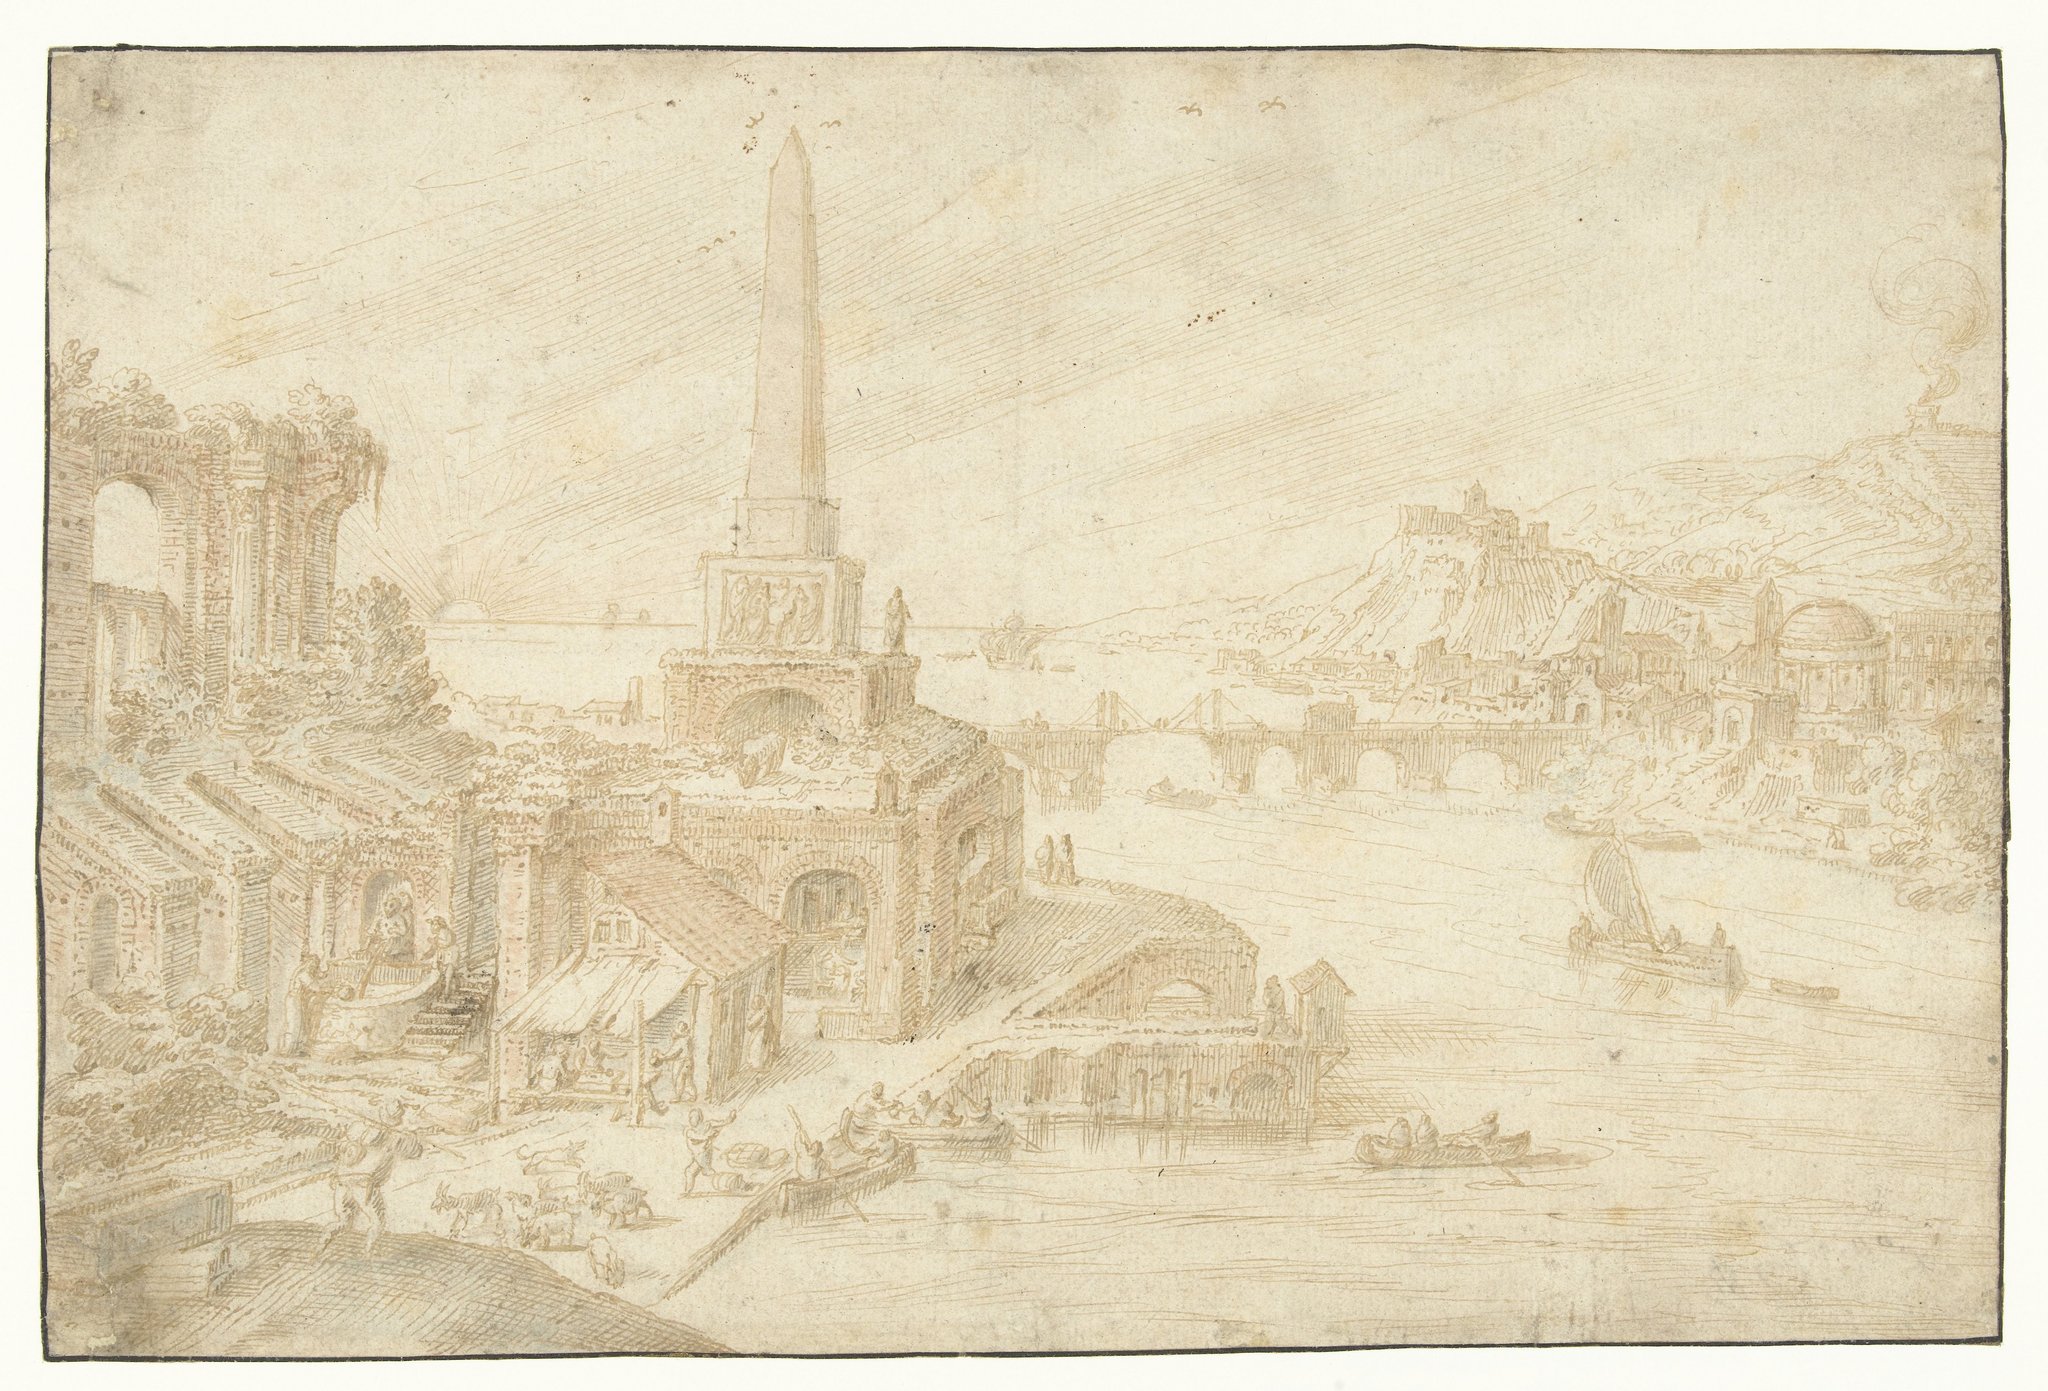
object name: design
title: Regionum, Rurium, Fundorumque (...)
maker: hendrick van cleve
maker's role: draughtsman, print maker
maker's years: 1525-1589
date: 1579-1589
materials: ink, paper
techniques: brush, pen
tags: obelisk, needle, landscape with ruins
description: Obelisk op een brede basis van baksteen; ernaast antieke ruïnes. Ontwerp voor een prent.